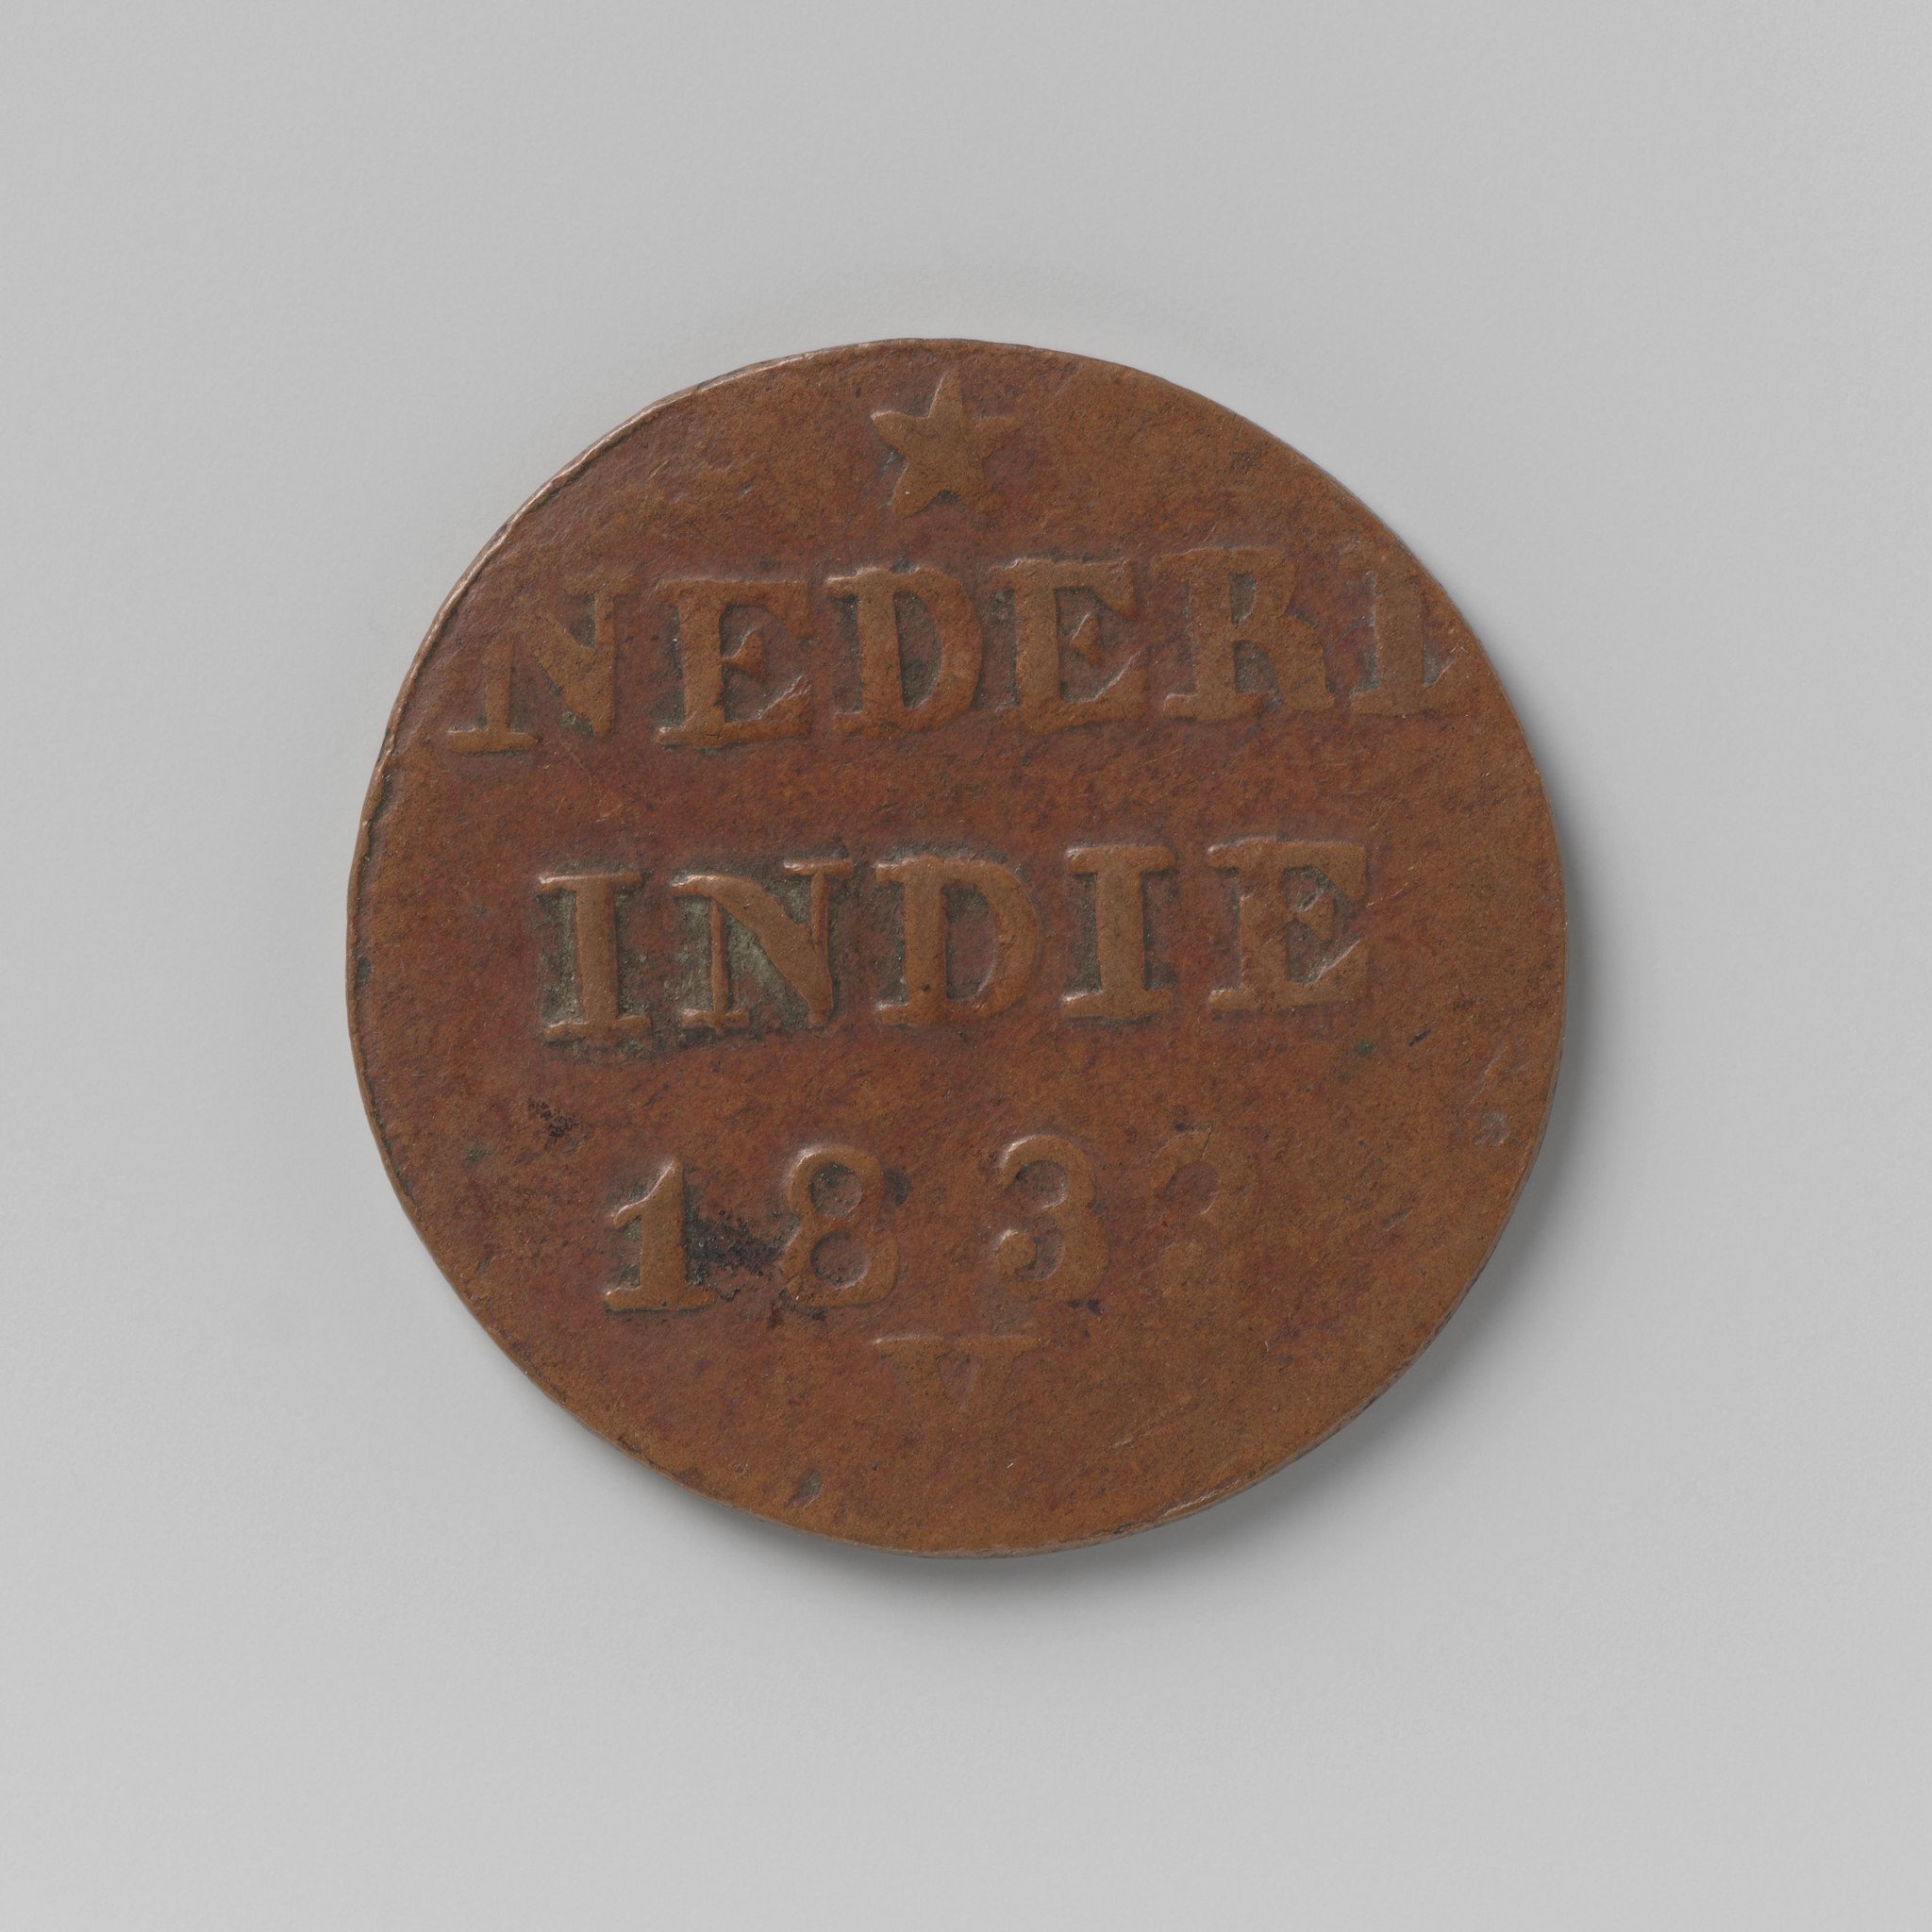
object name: coin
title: Cent van Nederlands Indië,1833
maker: william i of the netherlands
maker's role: koning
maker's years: 1772-1843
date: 1833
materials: copper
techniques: striking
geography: surabaya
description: Koperen munt. Voorzijde: tussen waarde-aanduiding I CT. gekroond rijkswapenschild. Keerzijde: tweeregelig opschrift, waarboven muntteken en waaronder jaartal. Daaronder letter V [=muntmeester De Vogel]. Gladde rand.